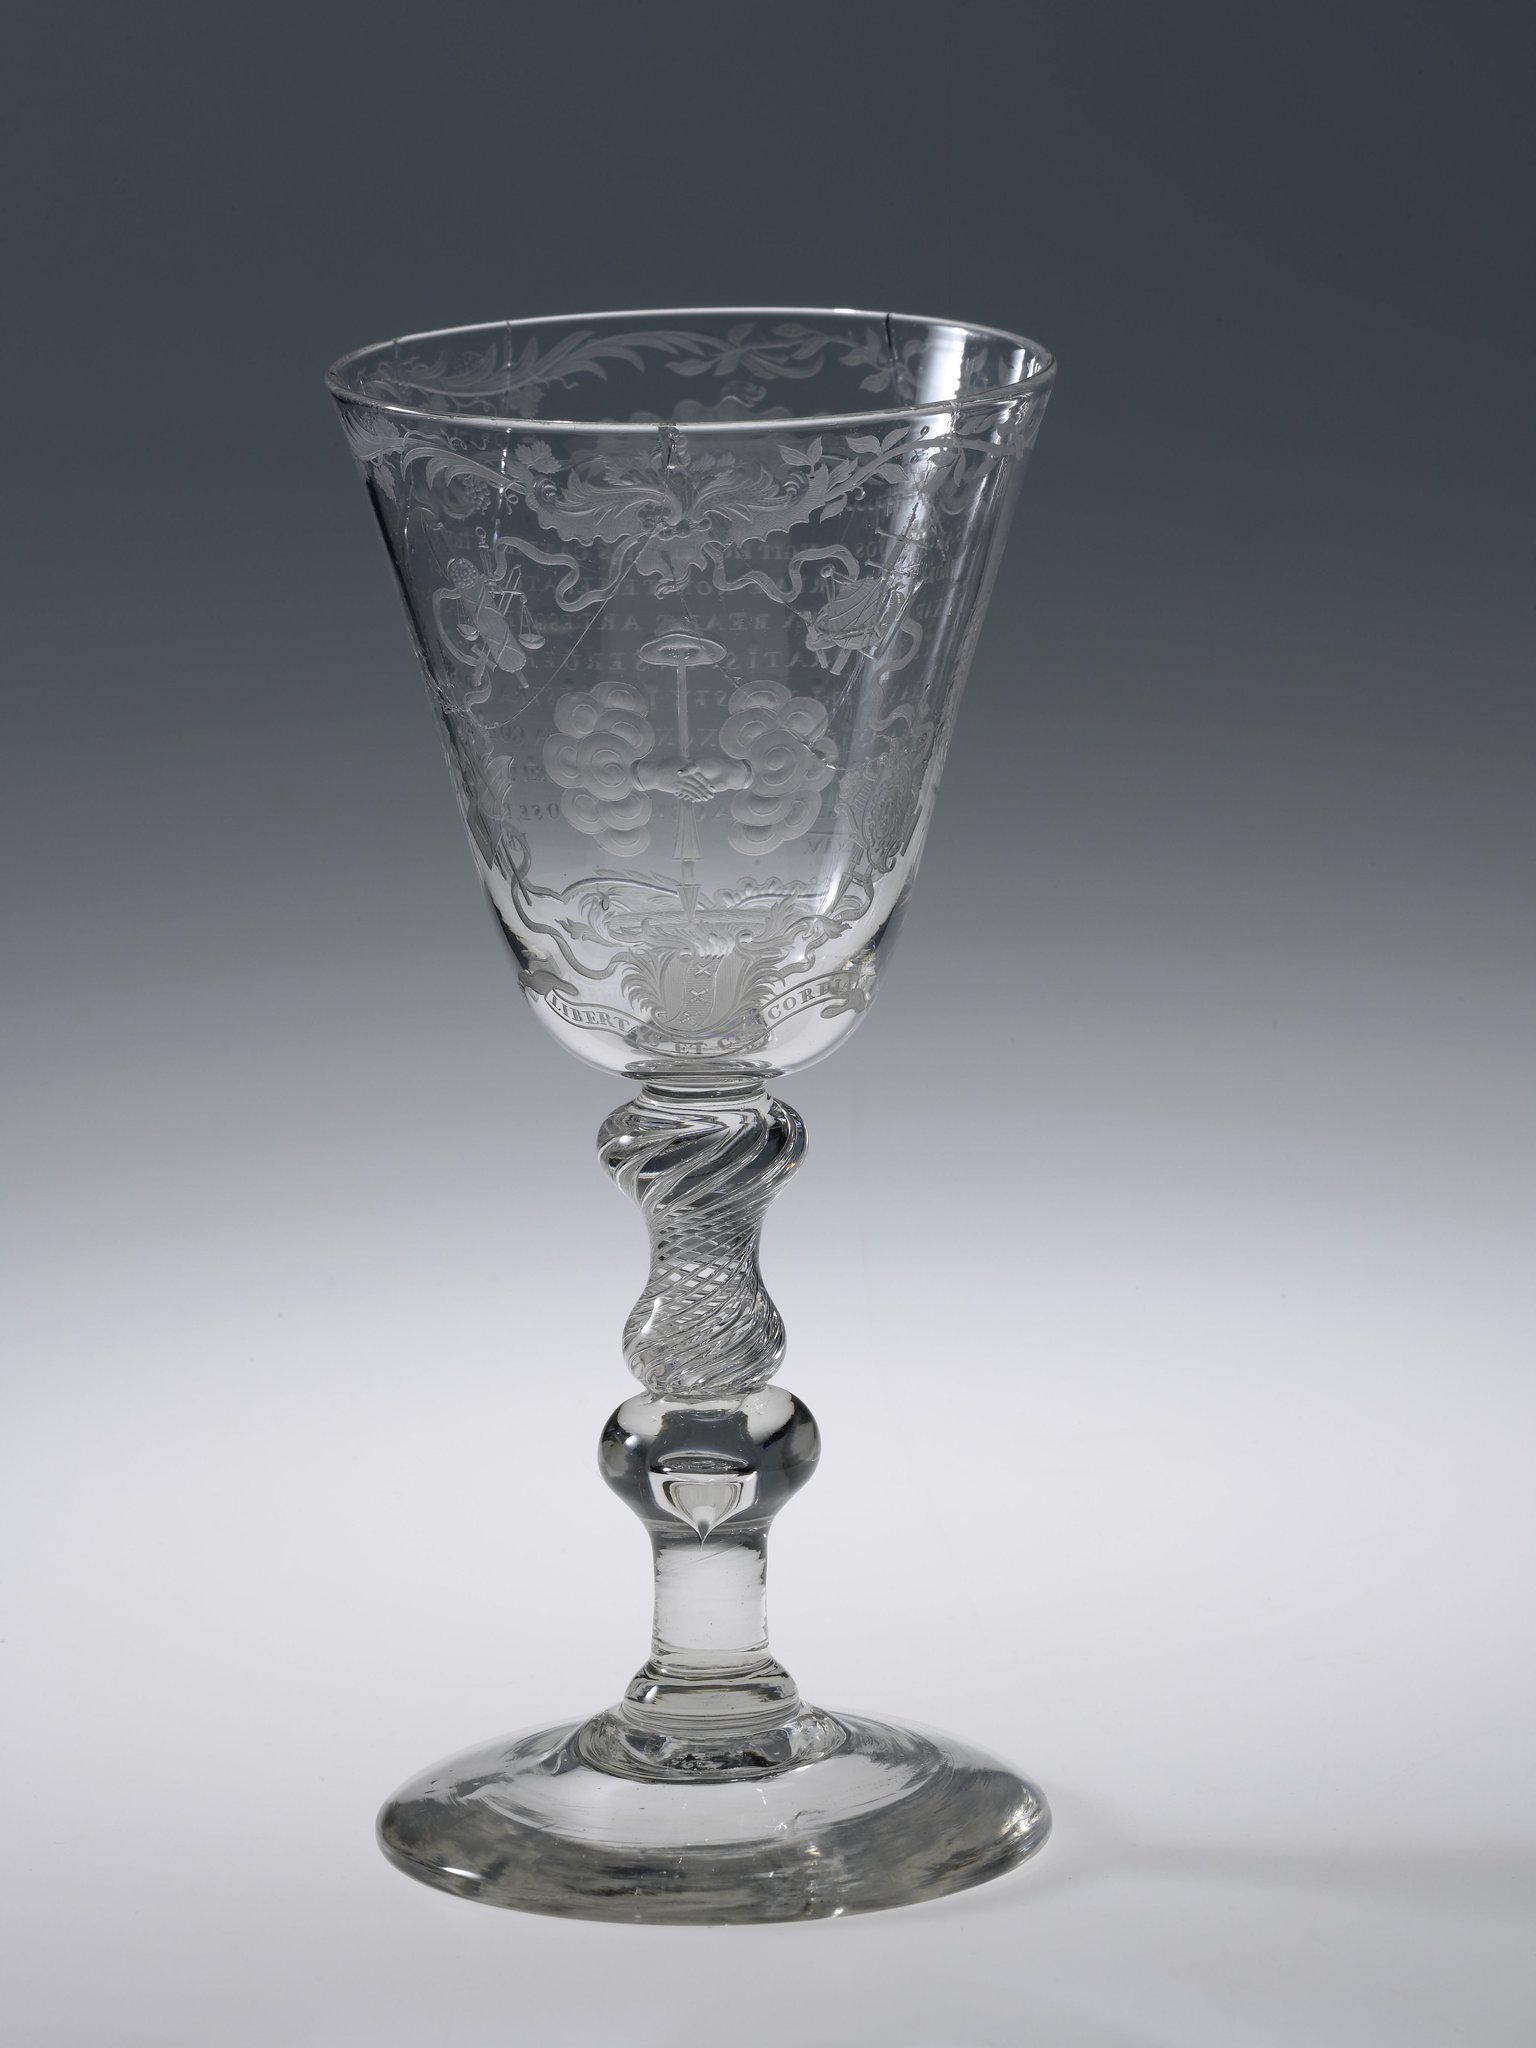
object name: goblet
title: Kelkglas van het genootschap Libertate et Concordia, ook wel het Vrijdagsche Gezelschap genaamd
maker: simon jacob sang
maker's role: glasgraveur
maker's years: 1720-1786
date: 1764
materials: glass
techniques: glassblowing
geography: amsterdam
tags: amsterdam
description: Gewelfde voet. Dubbele balusterstam, de onderste baluster met een luchtbel, de bovenste met luchtspiralen. Conische kelk met afgeronde bodem. Op de kelk de gegraveerde tekst: MUSARUM QUOS TANGIT HONOS, QUOS CANDIDA VIRTUS // CONPROBAT, ET PATRIAE NON TEMERATUS AMOR: // MAIUGENAE QUOS DONA BEANT, ARTESQUE TOGATAE // URBIS HONORATIS INSERUERE VIRIS // LUCE SACRA VENERI, PER SEX IAM LUSTRA SODALES // FOEDERA AMICITIAE NON VIOLATA COLUNT. // TESTIS ERIT CYATHUS, QUEM, POSTERA NORIT UT AESTAS // SACRARUNT GENIO, BACCHE IOCOSE, TUO. // MDCCLXIV // P.B.S.